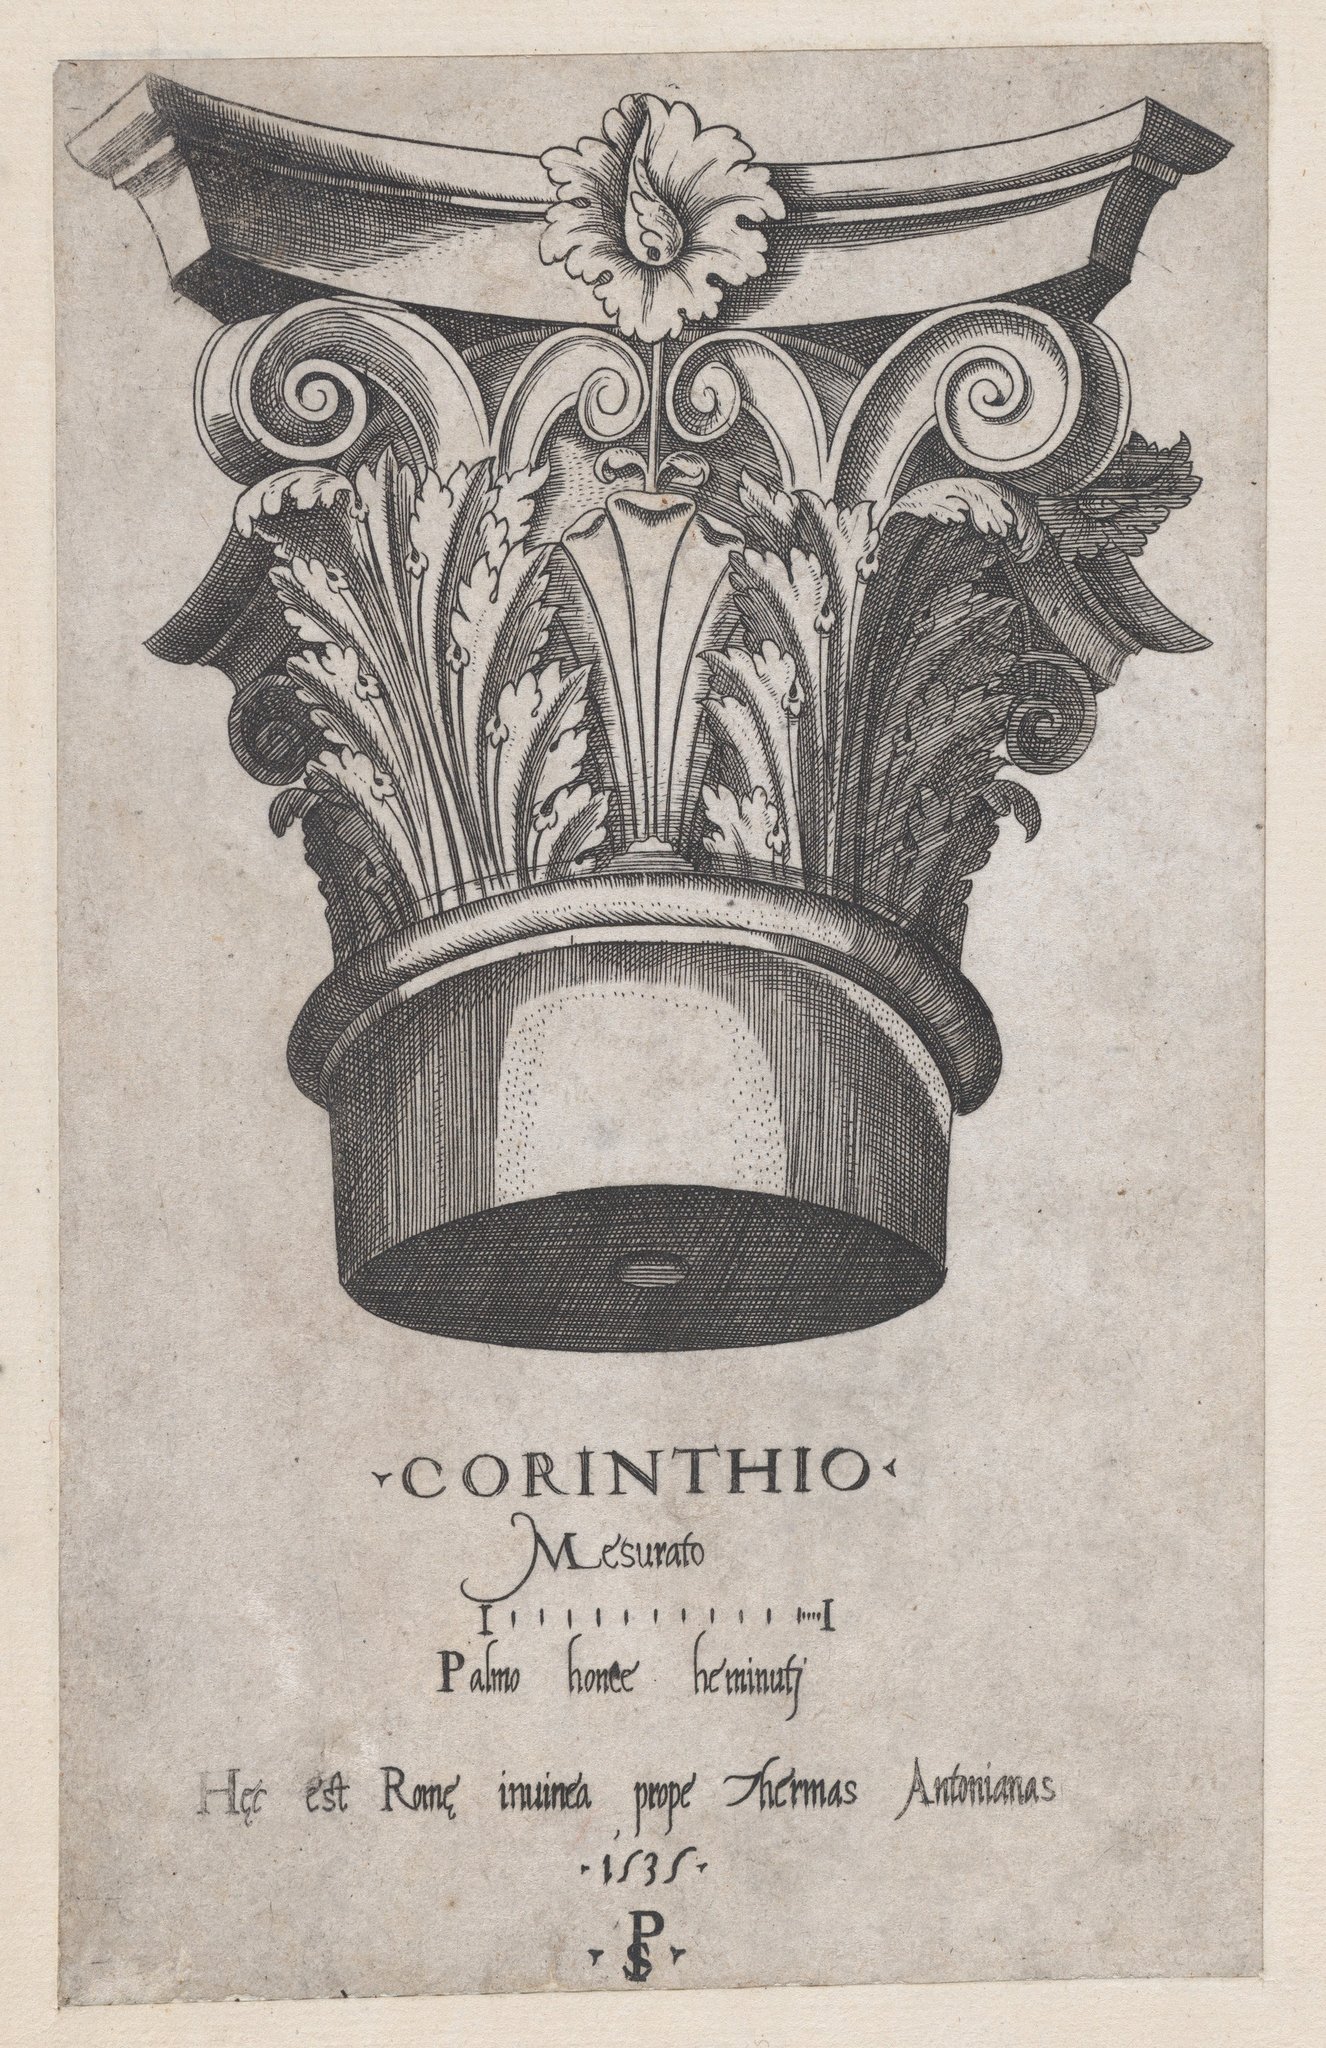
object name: print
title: Corinthian capital, from "Speculum Romanae Magnificentiae"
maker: master ps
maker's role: artist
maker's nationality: italian or french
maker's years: 1530-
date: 1535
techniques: engraving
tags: capitals